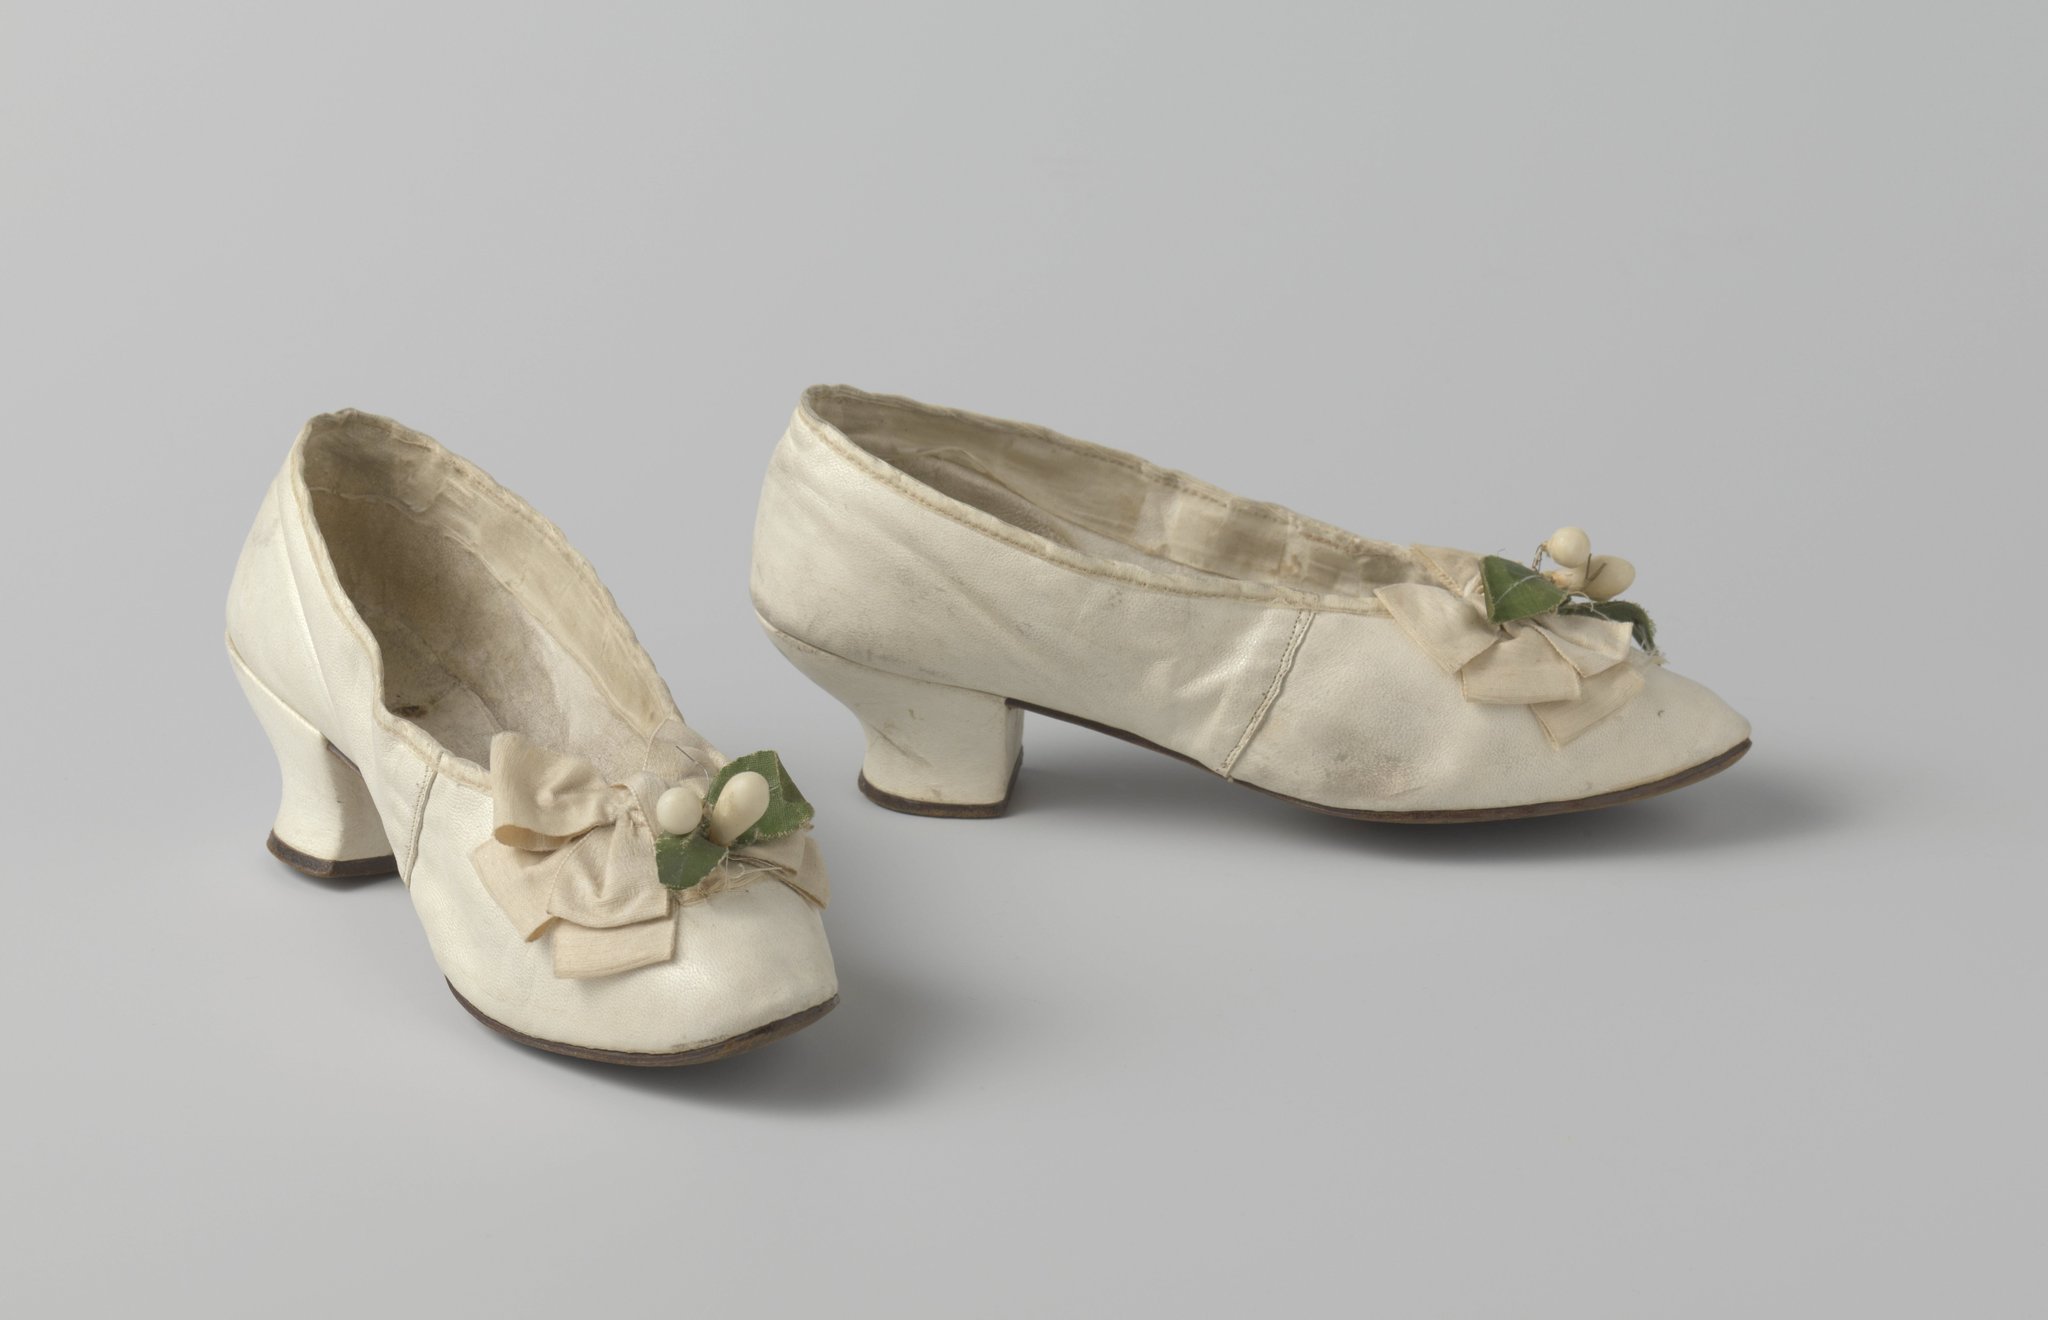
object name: shoe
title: Schoen van wit chroomleer met Weense hak en afgeronde puntneus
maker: Anonymous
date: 1880-1885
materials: leather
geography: netherlands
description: Schoen van wit chroomleer met Weense hak. Afgeronde puntneus. Hoorde oorspronkelijk niet bij de bruidsjapon.